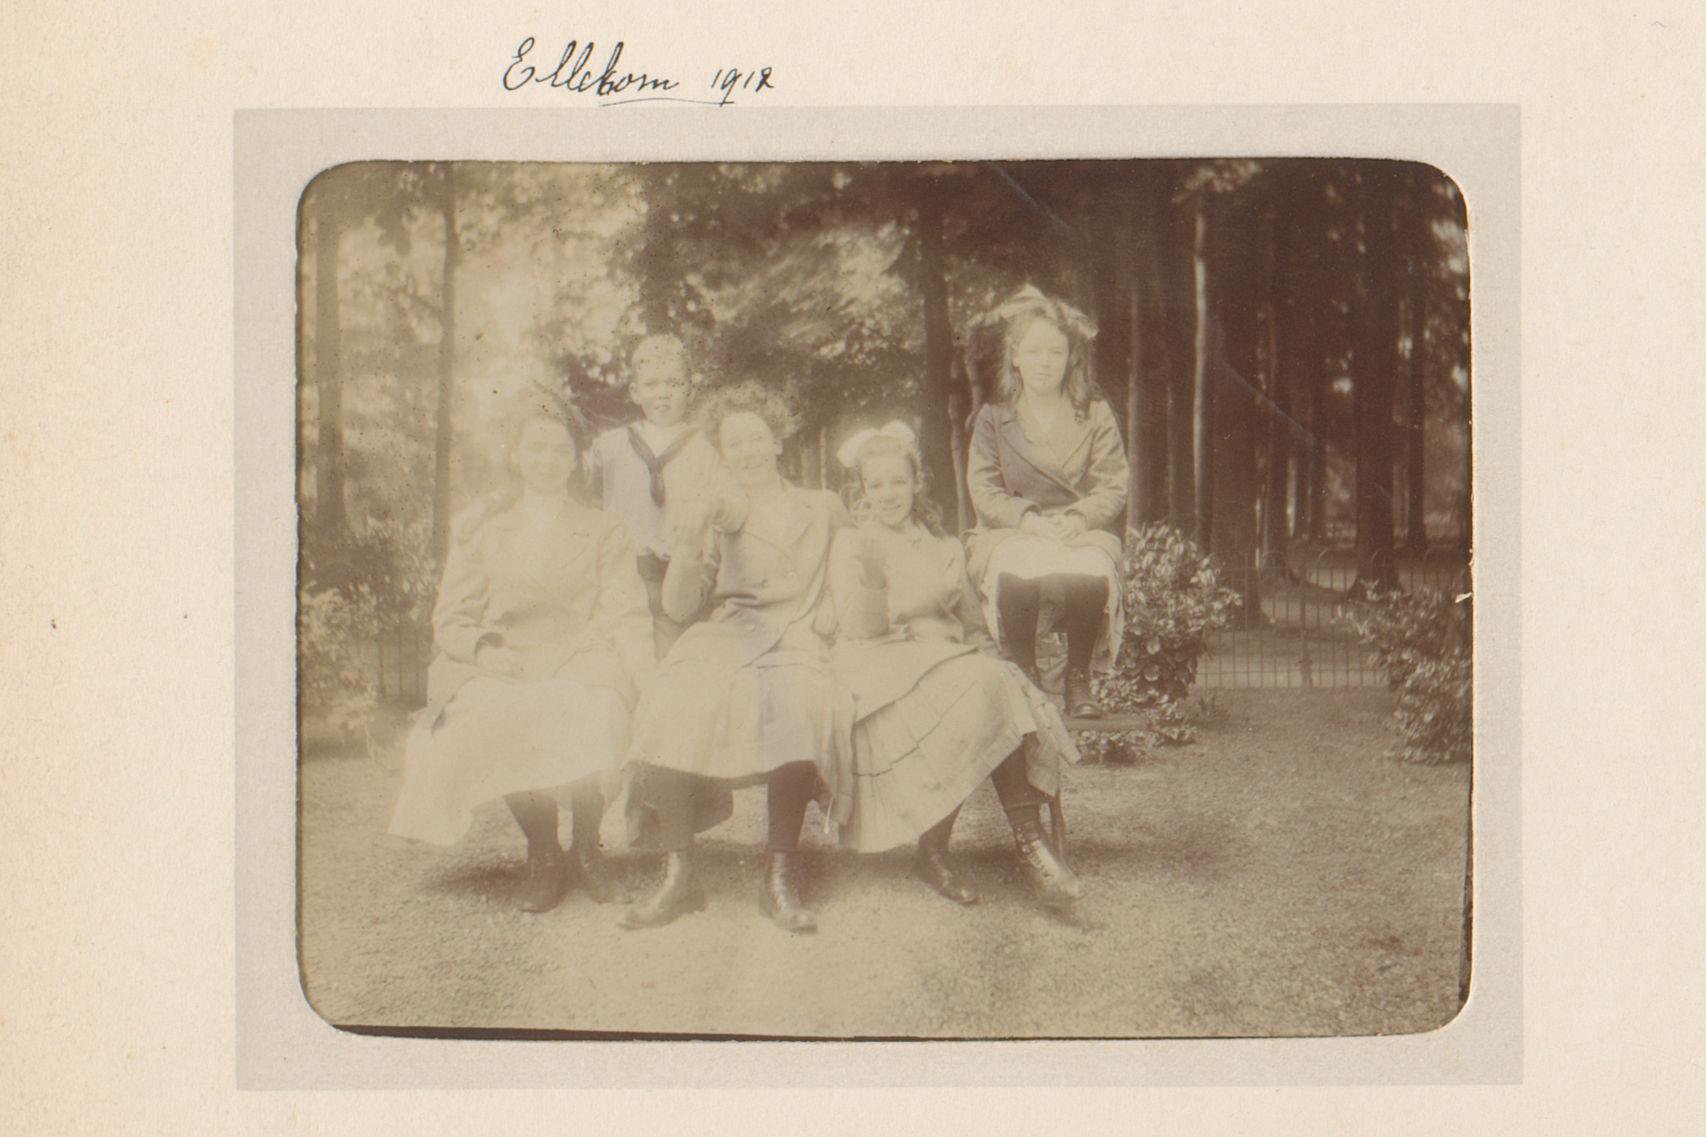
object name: album leaf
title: Groepsportret van vier meisjes en een jongen in een tuin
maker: liesbeth overhoff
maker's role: fotograaf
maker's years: 1895-1969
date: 1912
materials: paper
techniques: gelatin silver print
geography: ellecom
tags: girl (child between toddler and youth) (+ four persons), boy (child between toddler and youth), garden, historical persons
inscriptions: inscription: ‘Ellekom 1912’